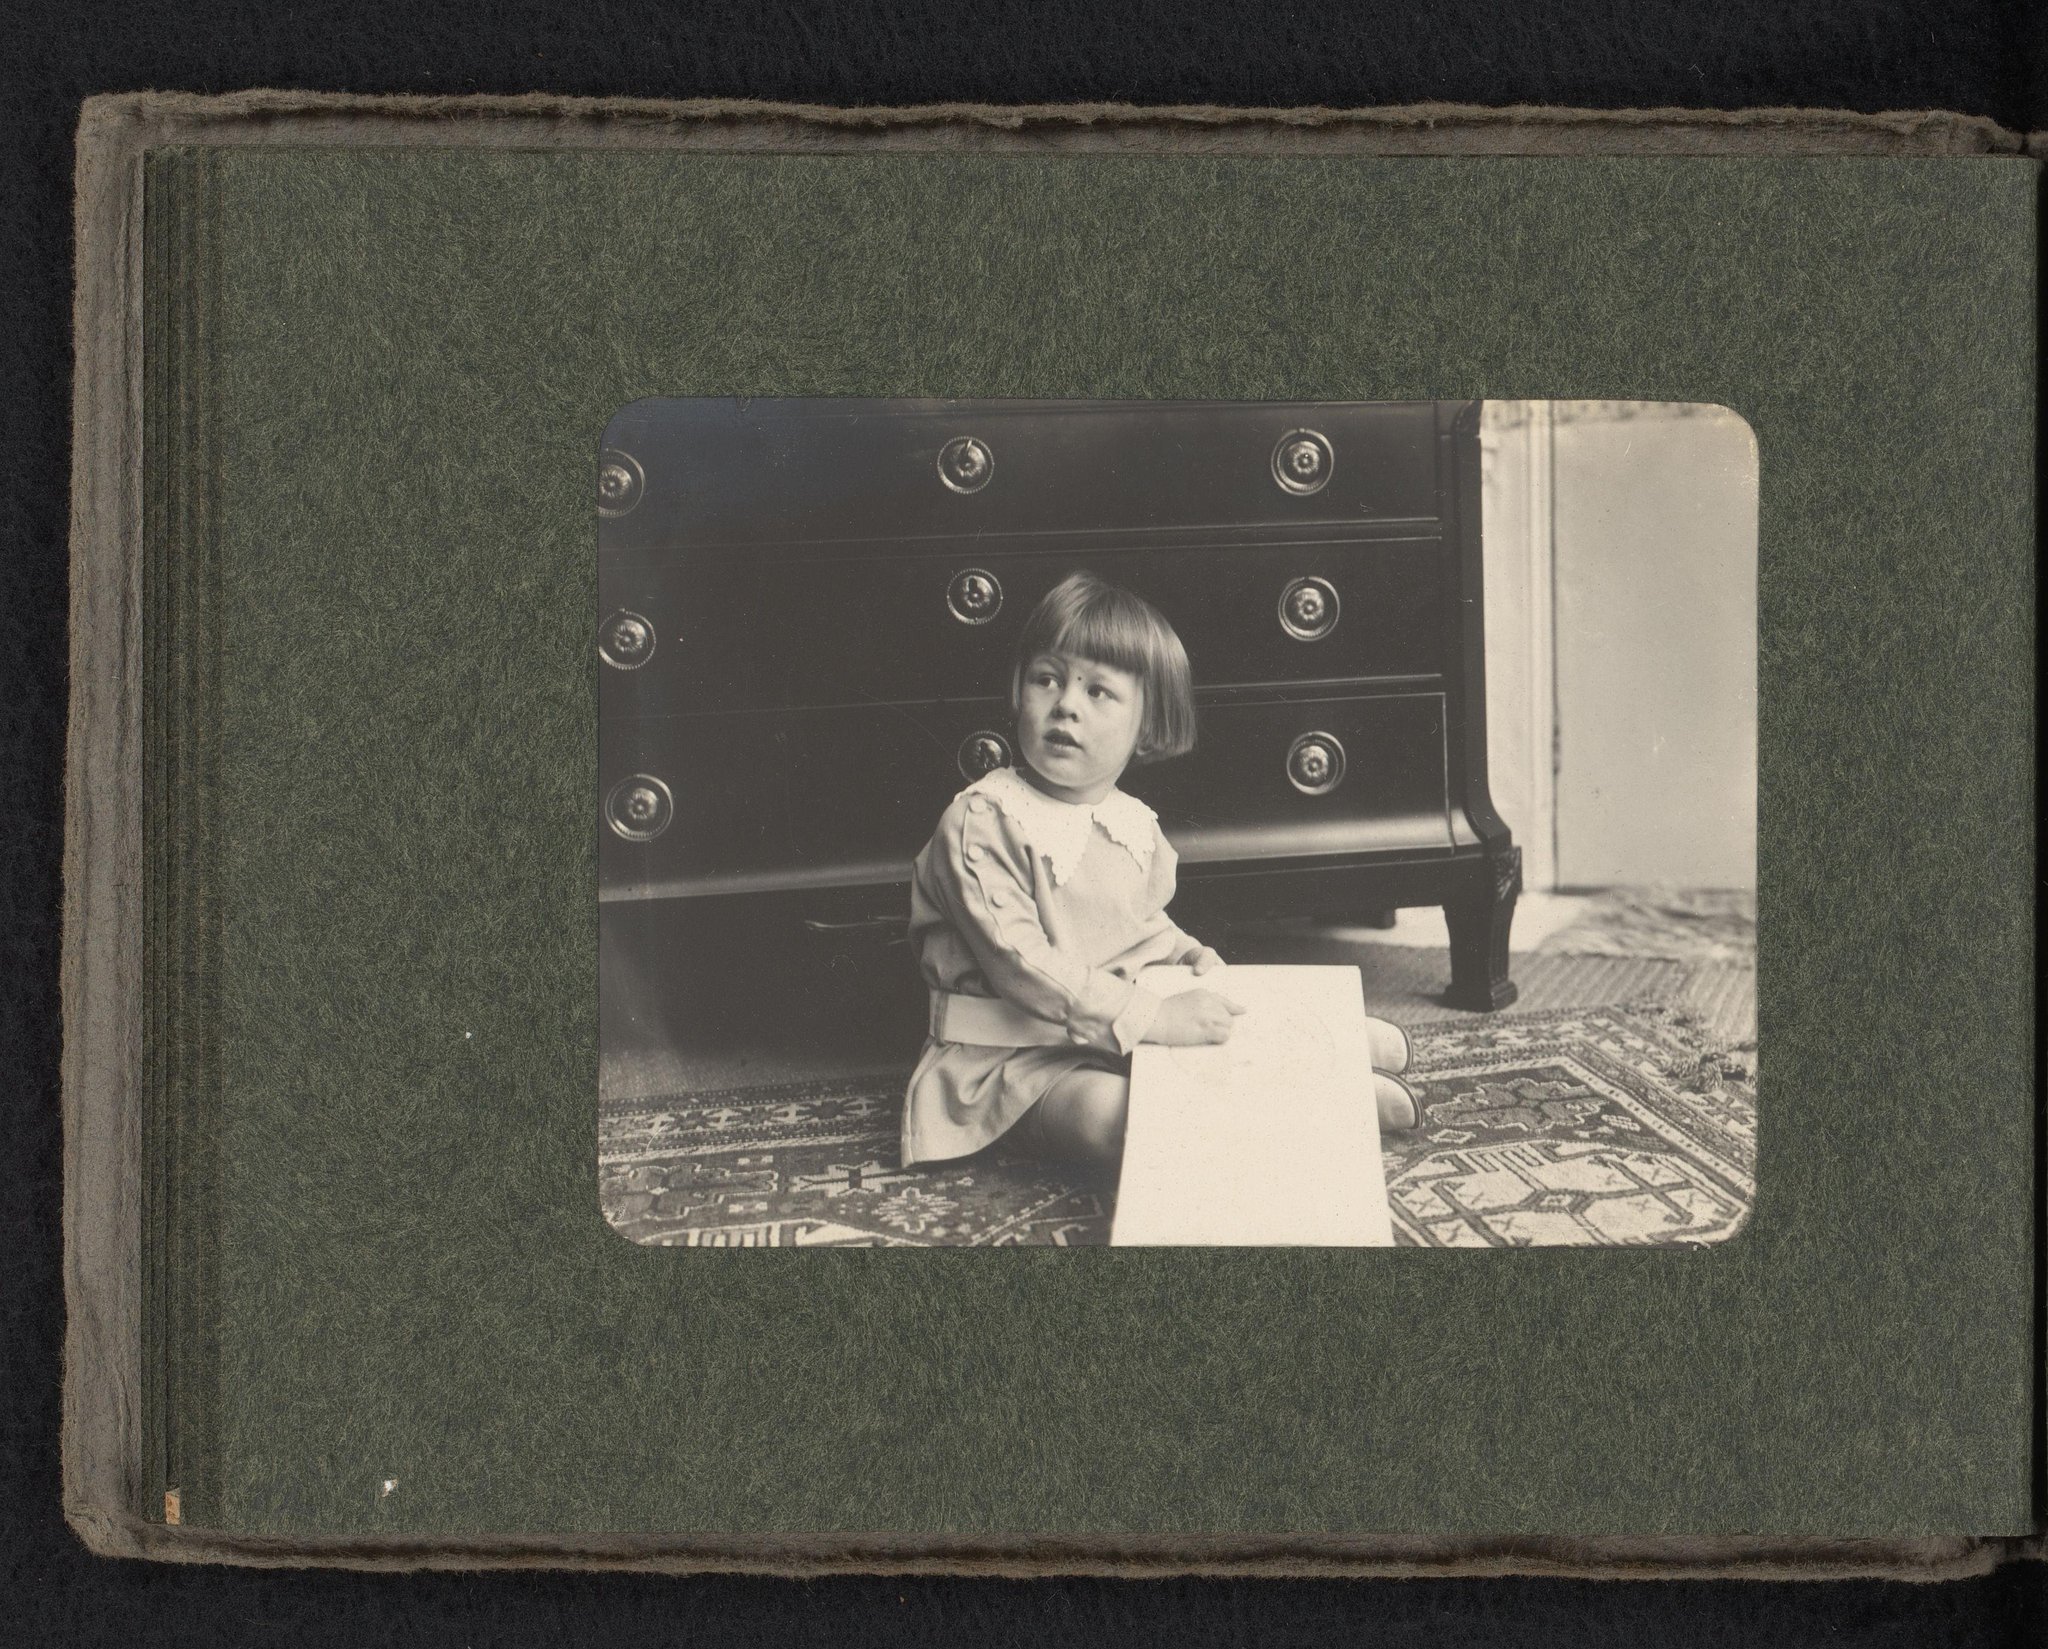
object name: album leaf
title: Cay van den Berg, lezend op de grond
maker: hendrik herman van den berg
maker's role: amateurfotograaf, jurist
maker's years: 1875-1944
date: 1912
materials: paper, cardboard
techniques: gelatin silver print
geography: laren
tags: carel frederik van den berg (cay), toddler, reading, historical persons